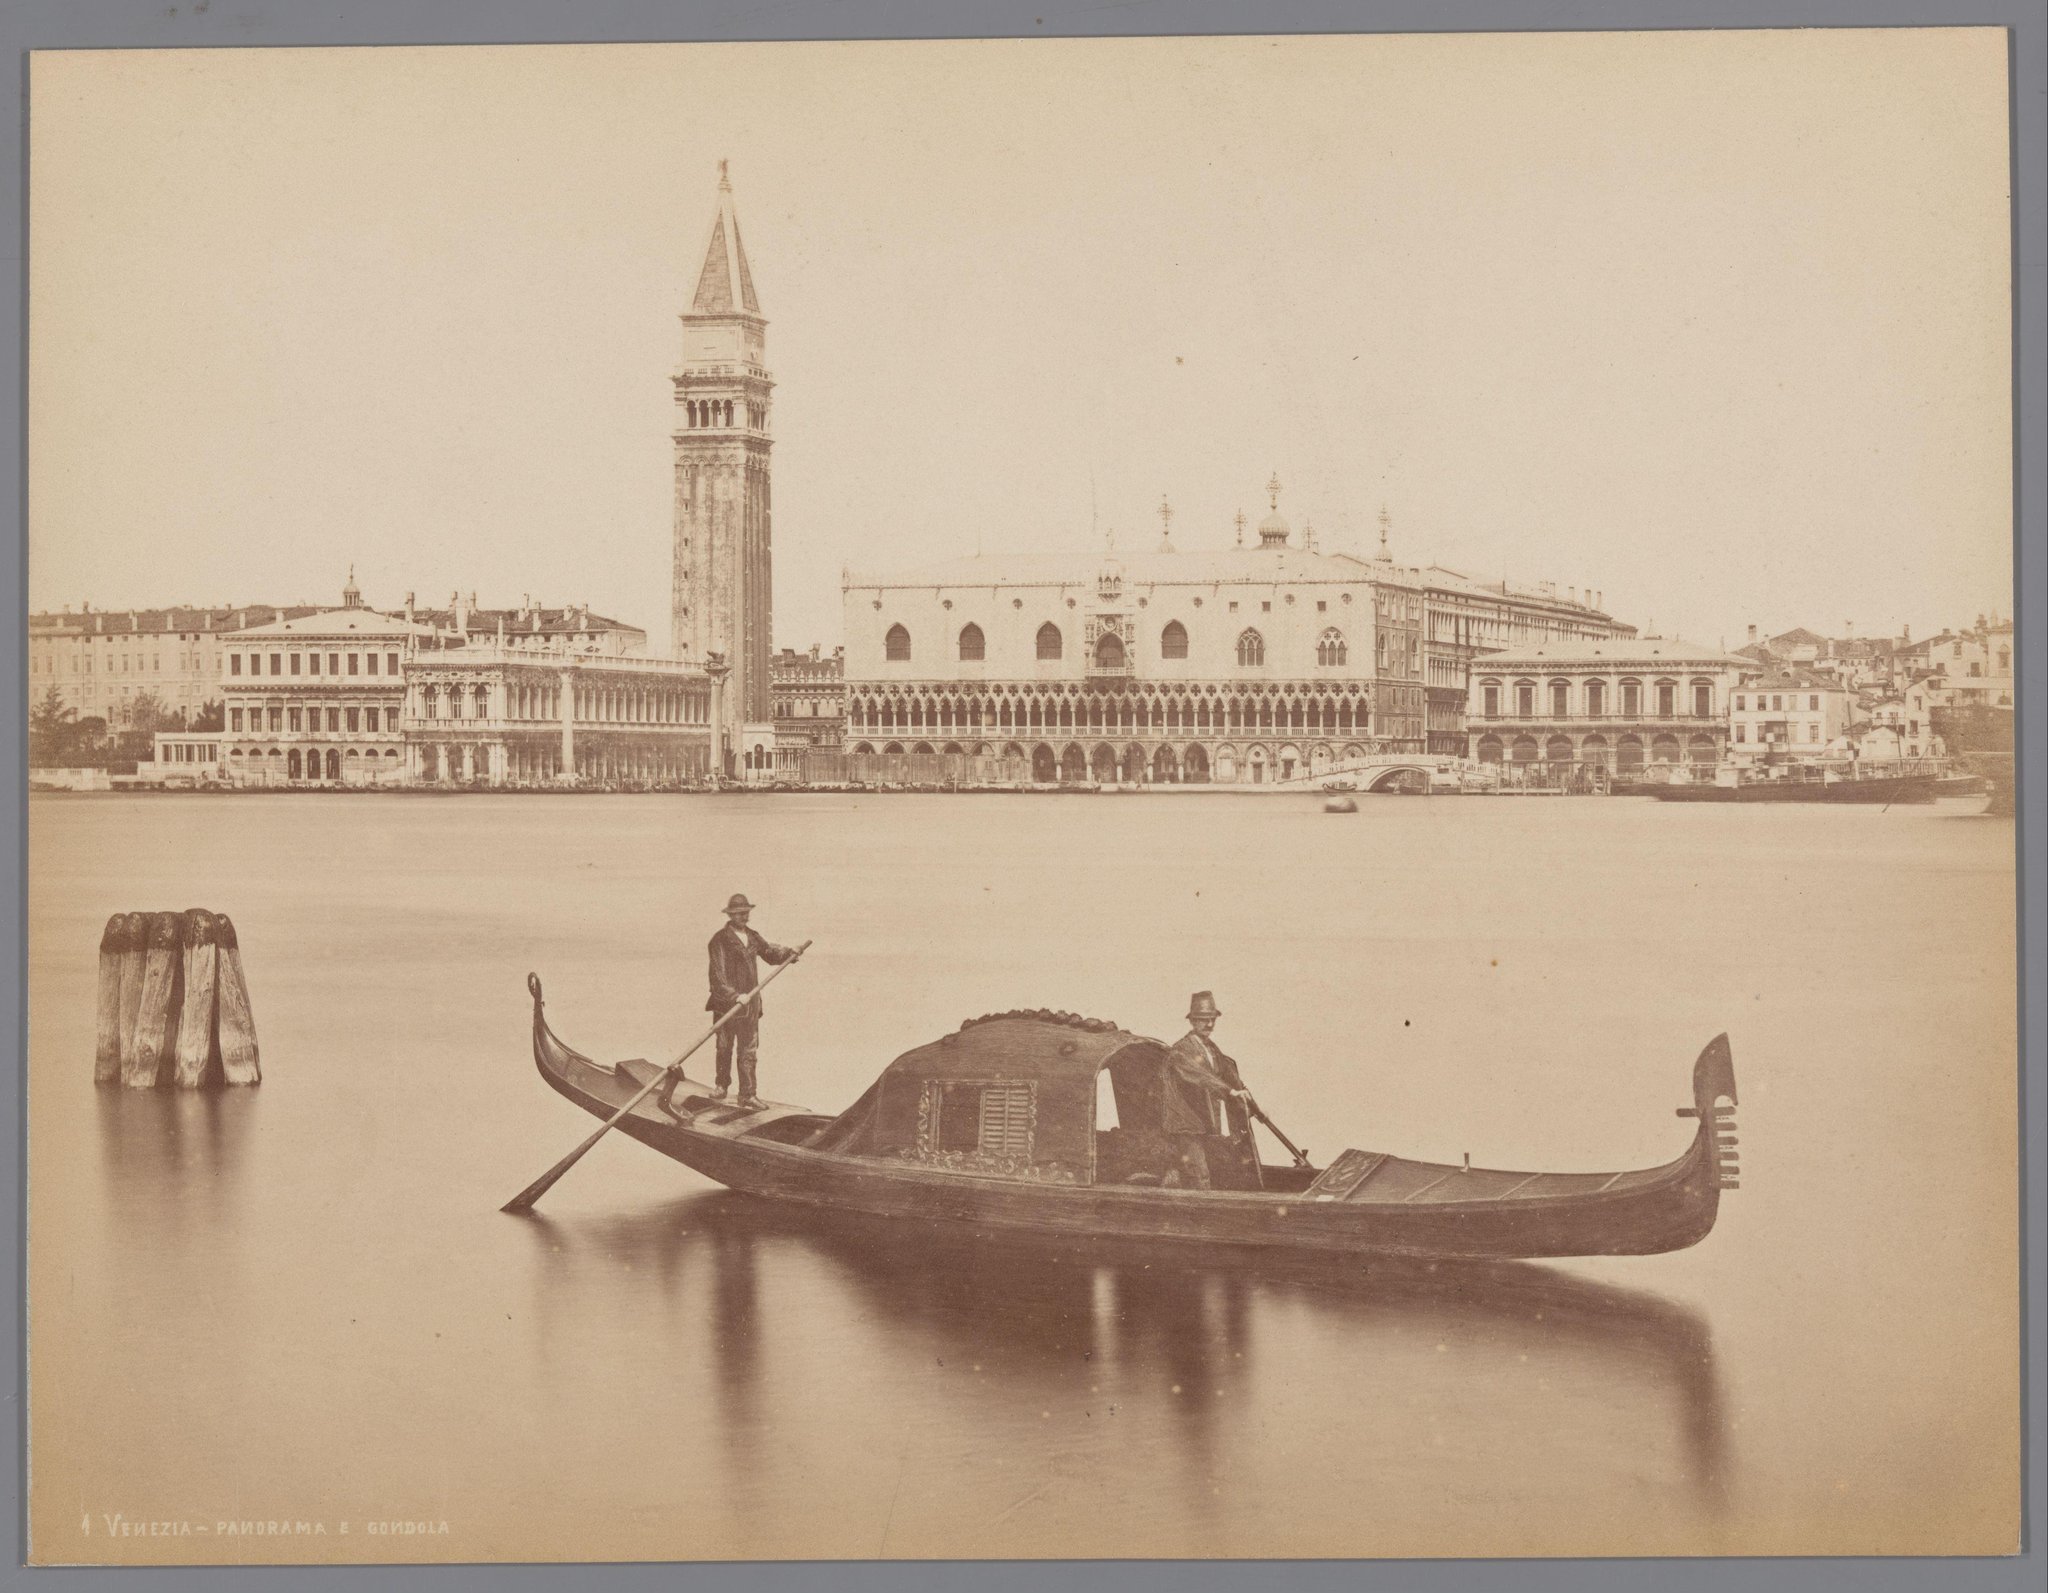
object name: photograph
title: Venezia - Panorama e Gondola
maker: Anonymous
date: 1851-1900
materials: cardboard, paper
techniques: albumen print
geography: venice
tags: gondola, prospect of city, town panorama, silhouette of city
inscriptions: number: ‘1’